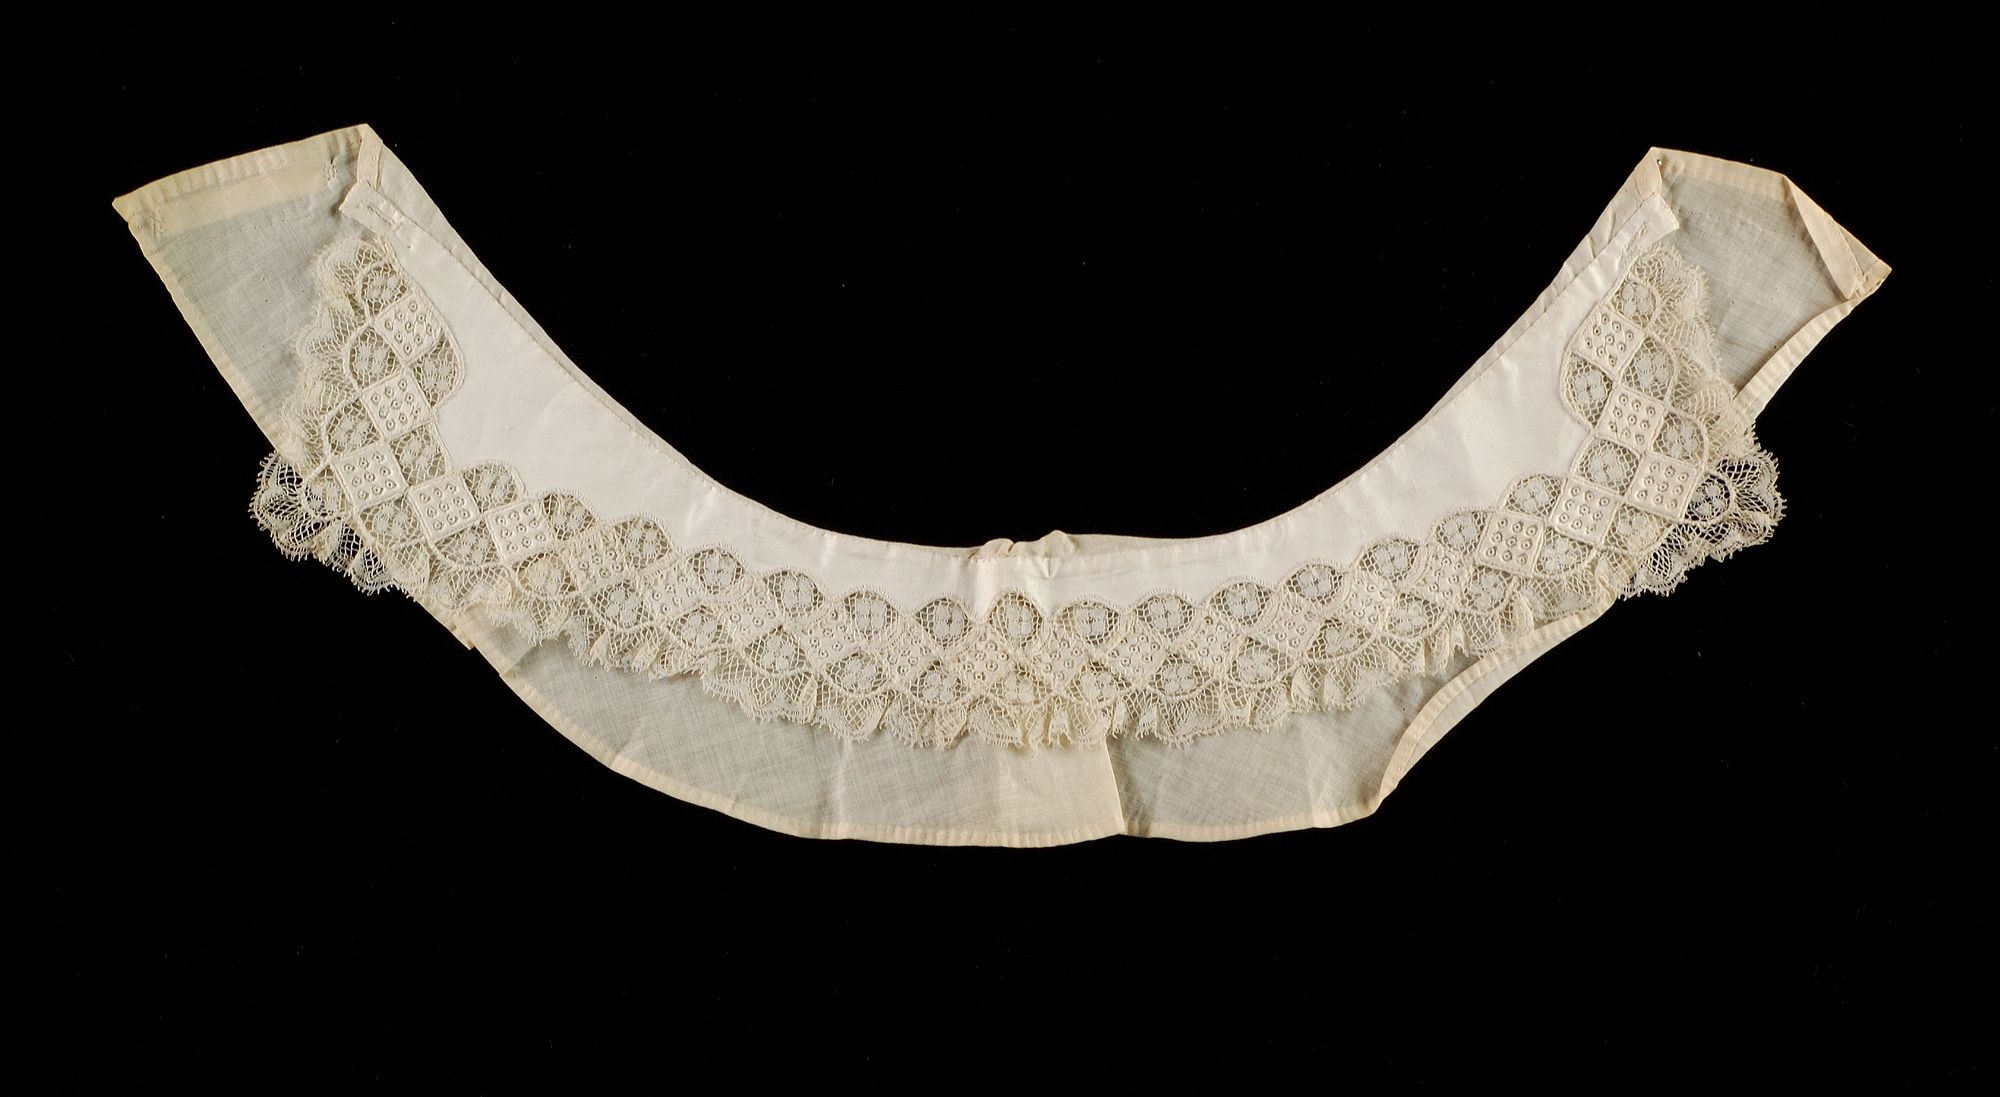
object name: collar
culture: american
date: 1860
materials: linen